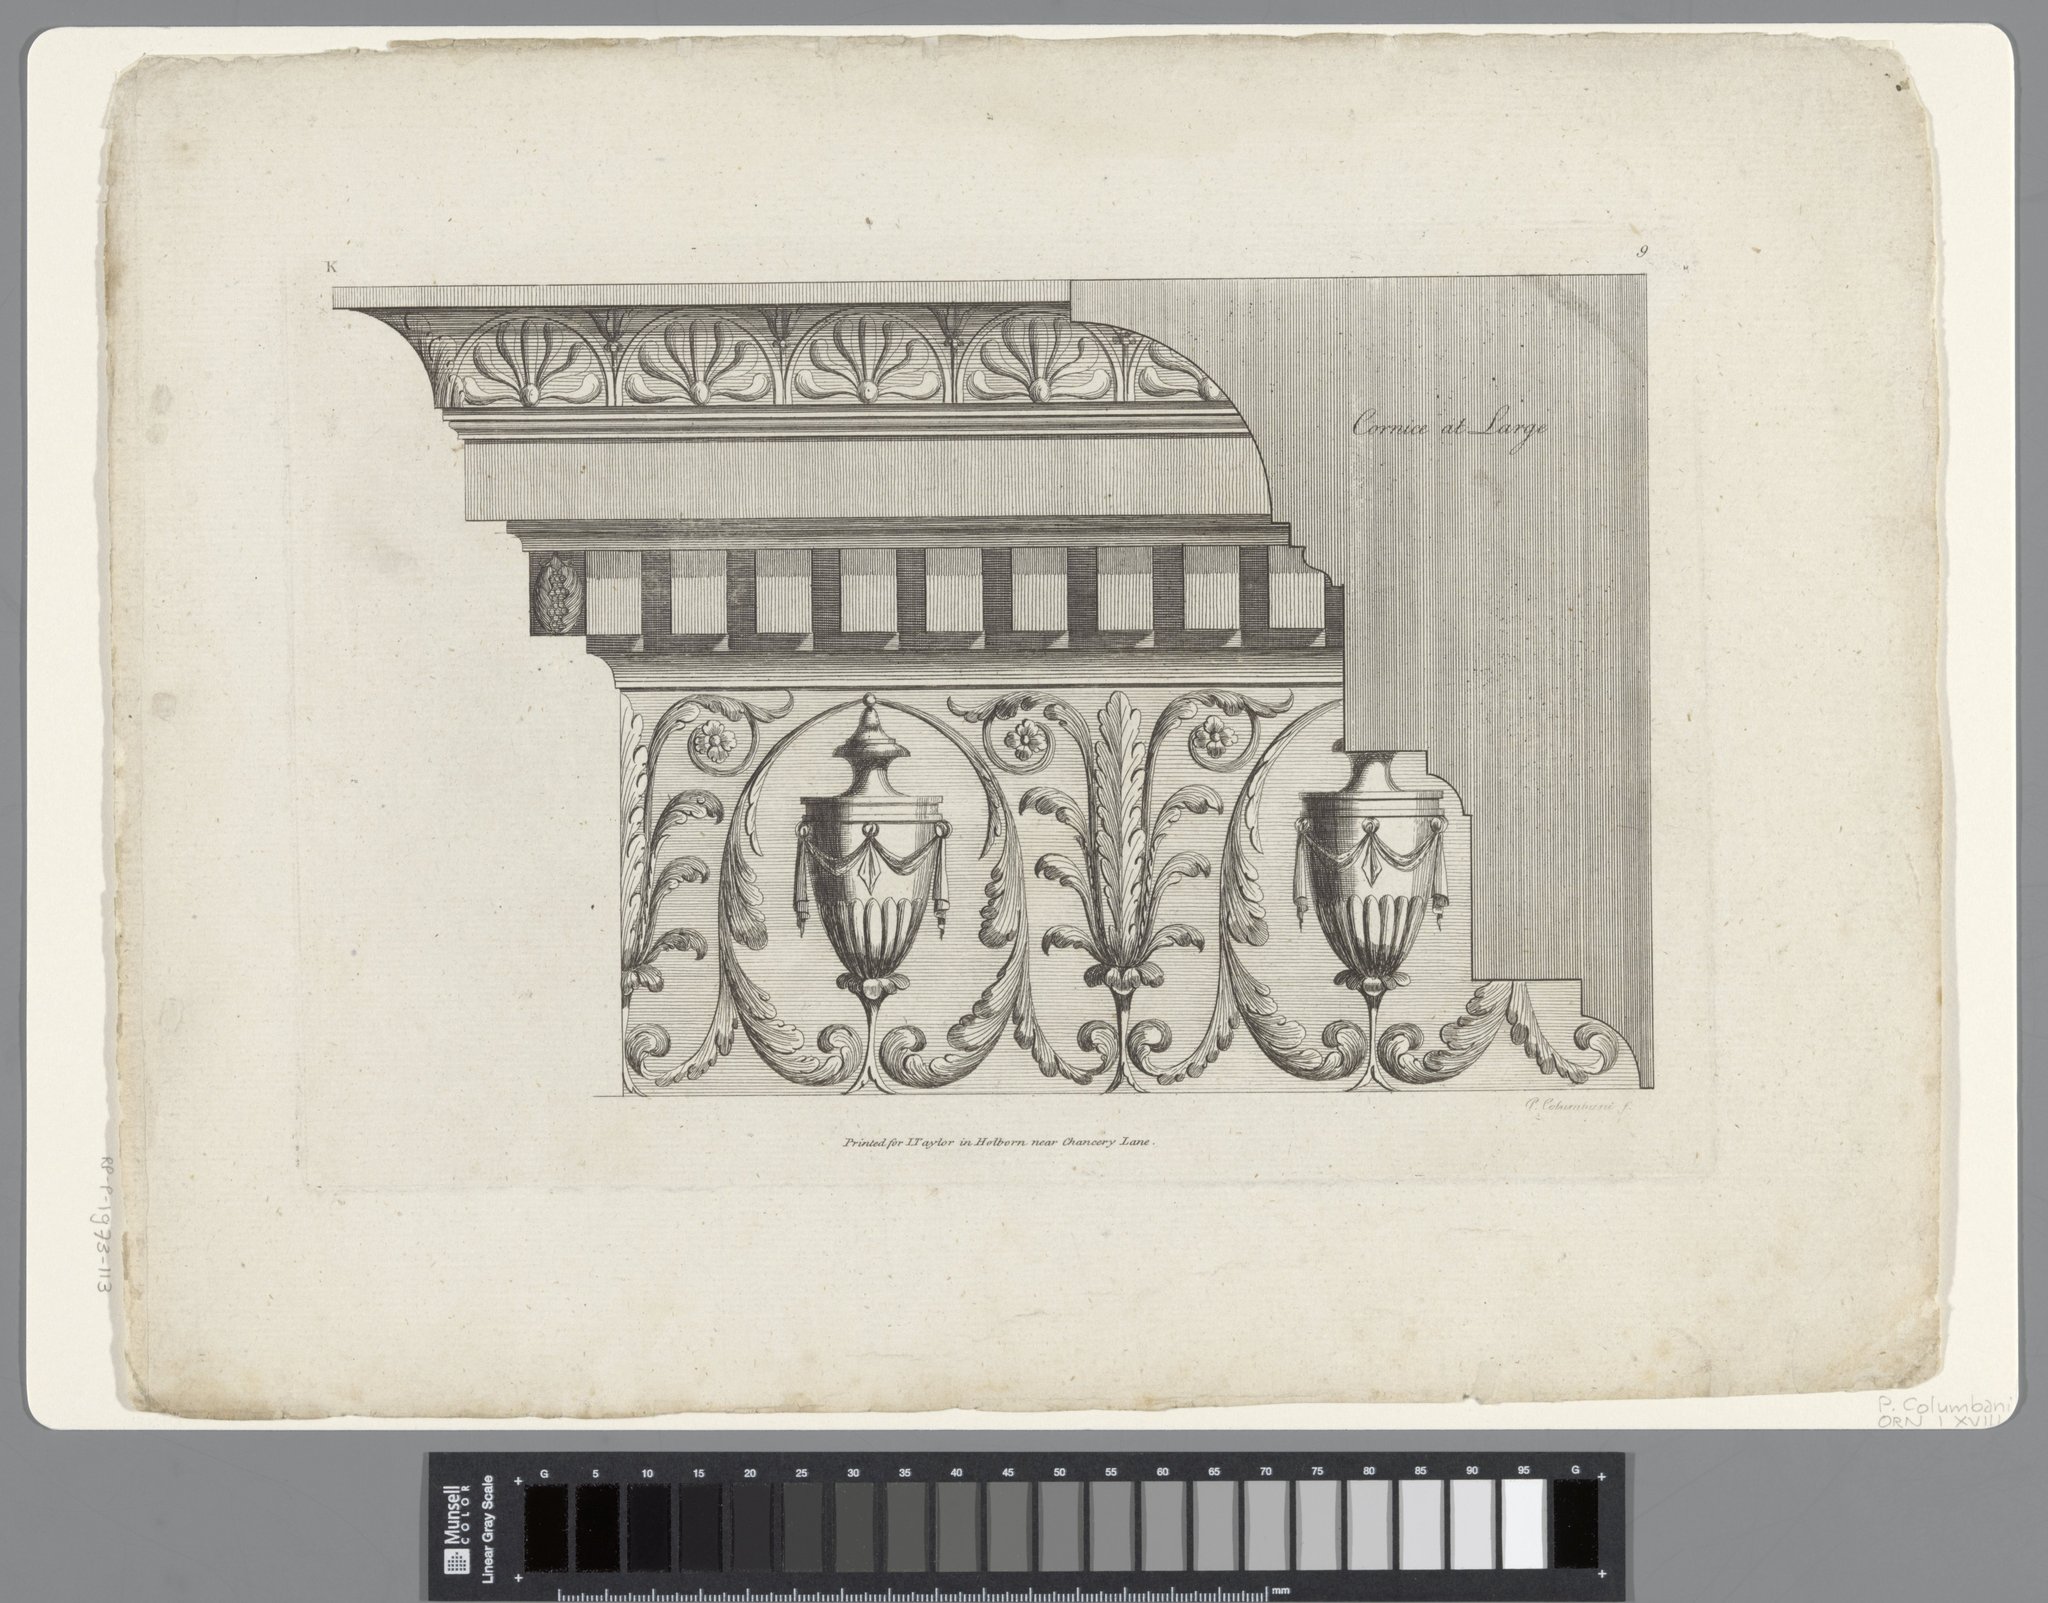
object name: print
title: Kapitelen, ornamentranden, kroonlijsten en schoorsteenmantels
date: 1776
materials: paper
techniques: etching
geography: london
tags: vase ~ ornament, other architectural details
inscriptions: collector's mark: Lugt 2228, collector's mark: Lugt 2760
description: Titelprent bij een reeks van 12 ornamentprenten.